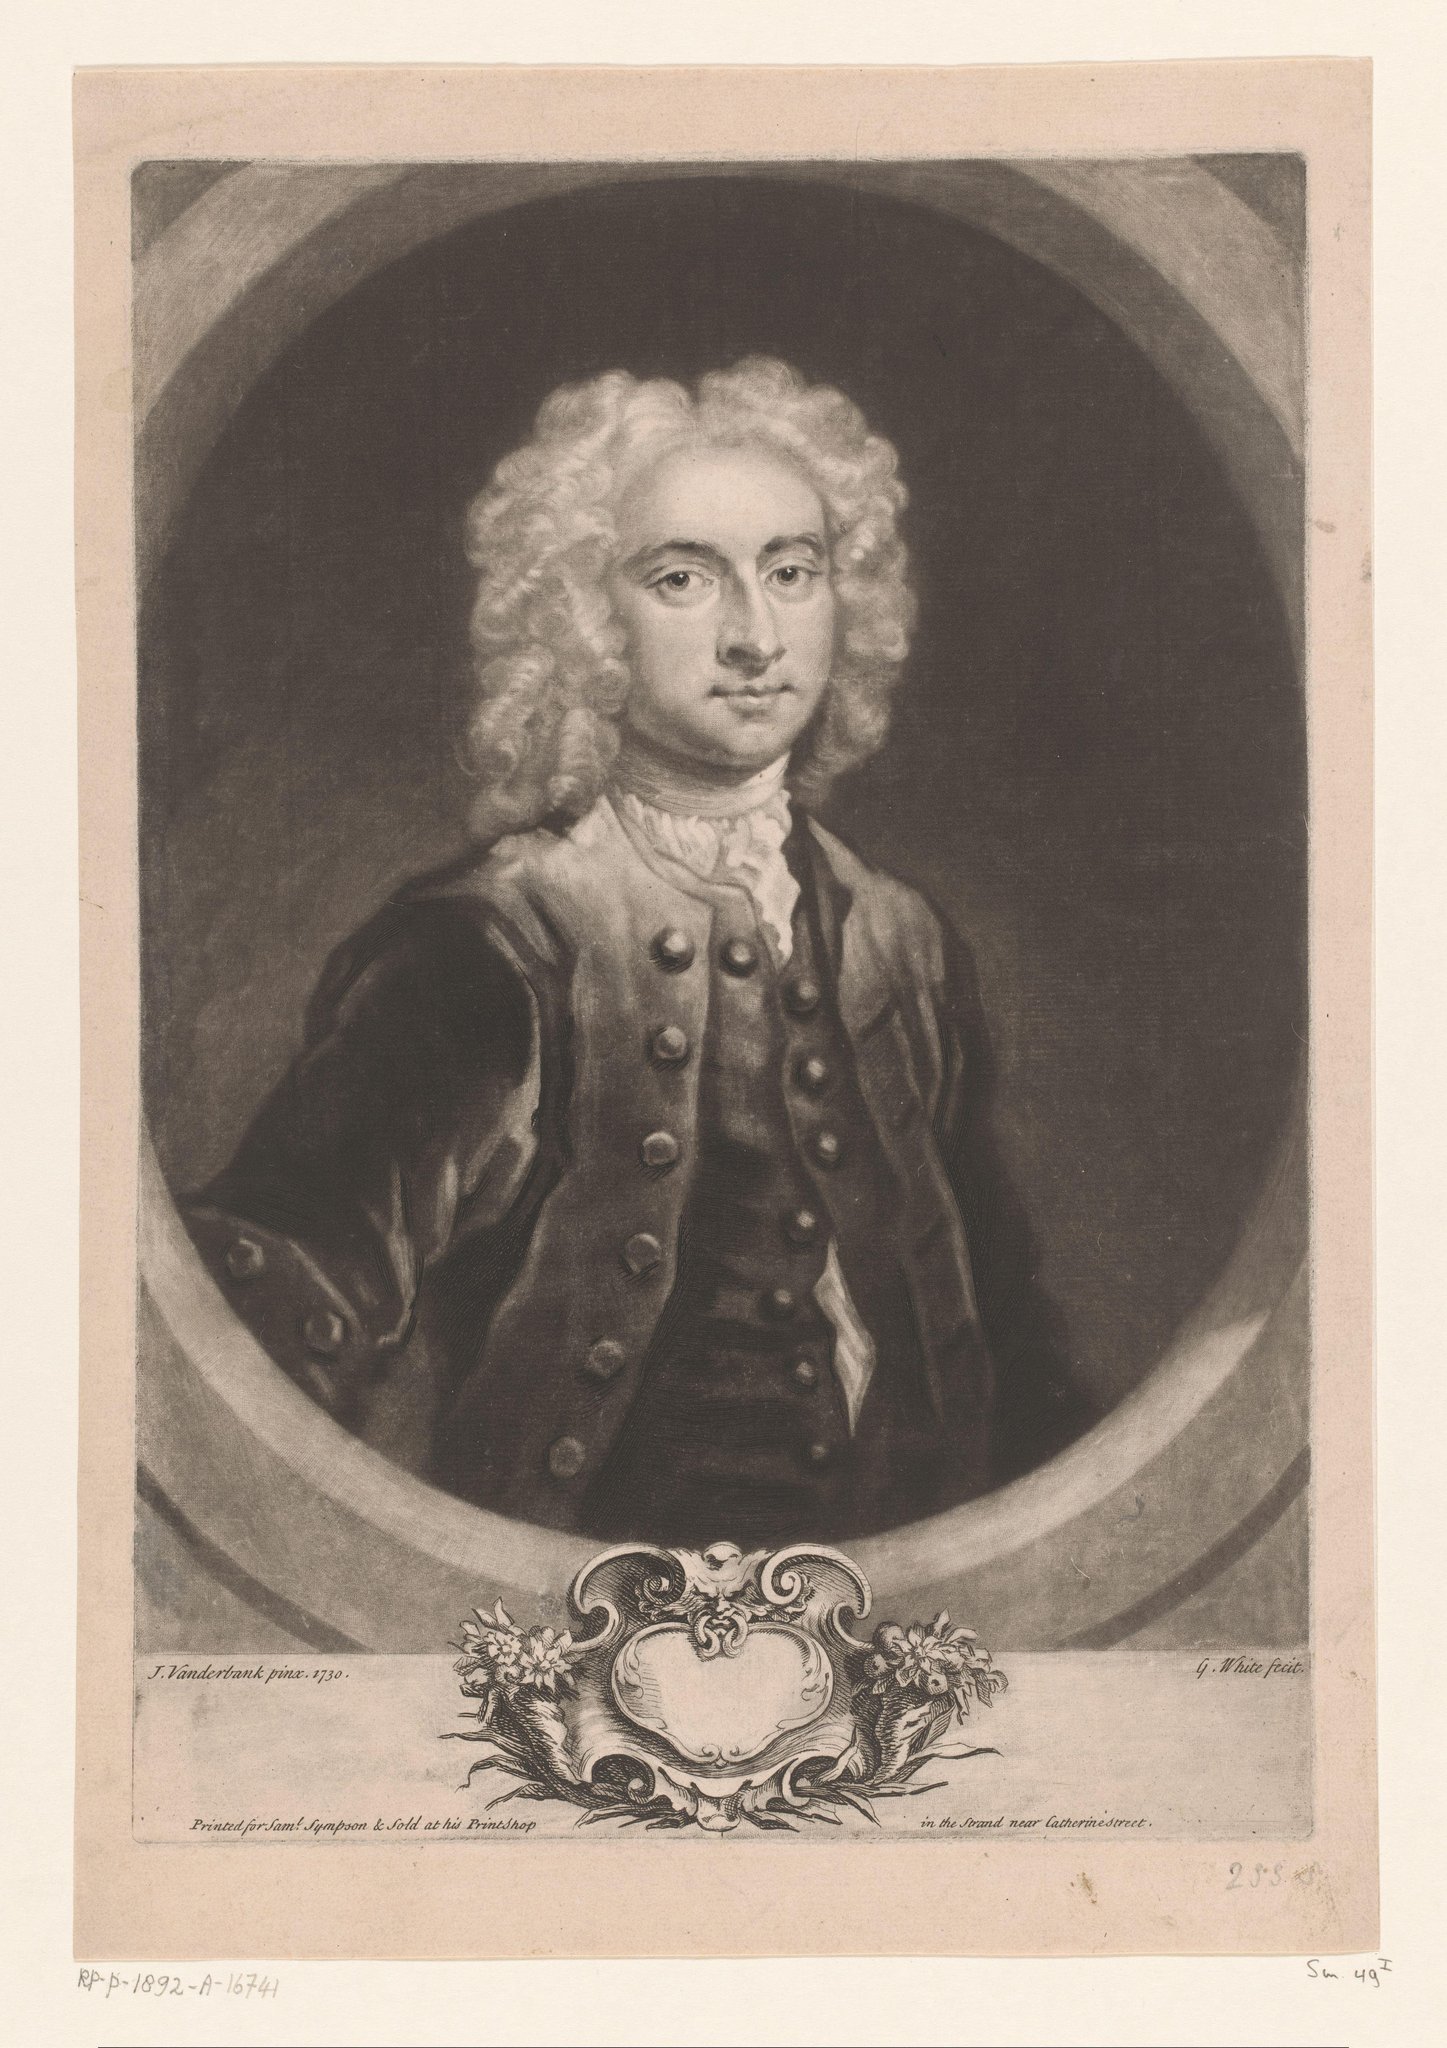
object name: print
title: Portret van Thomas Symonds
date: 1730-1732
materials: paper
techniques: mezzotint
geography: london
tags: historical persons, physician, doctor (+ portrait of scholar, scientist)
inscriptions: collector's mark: Lugt 2228